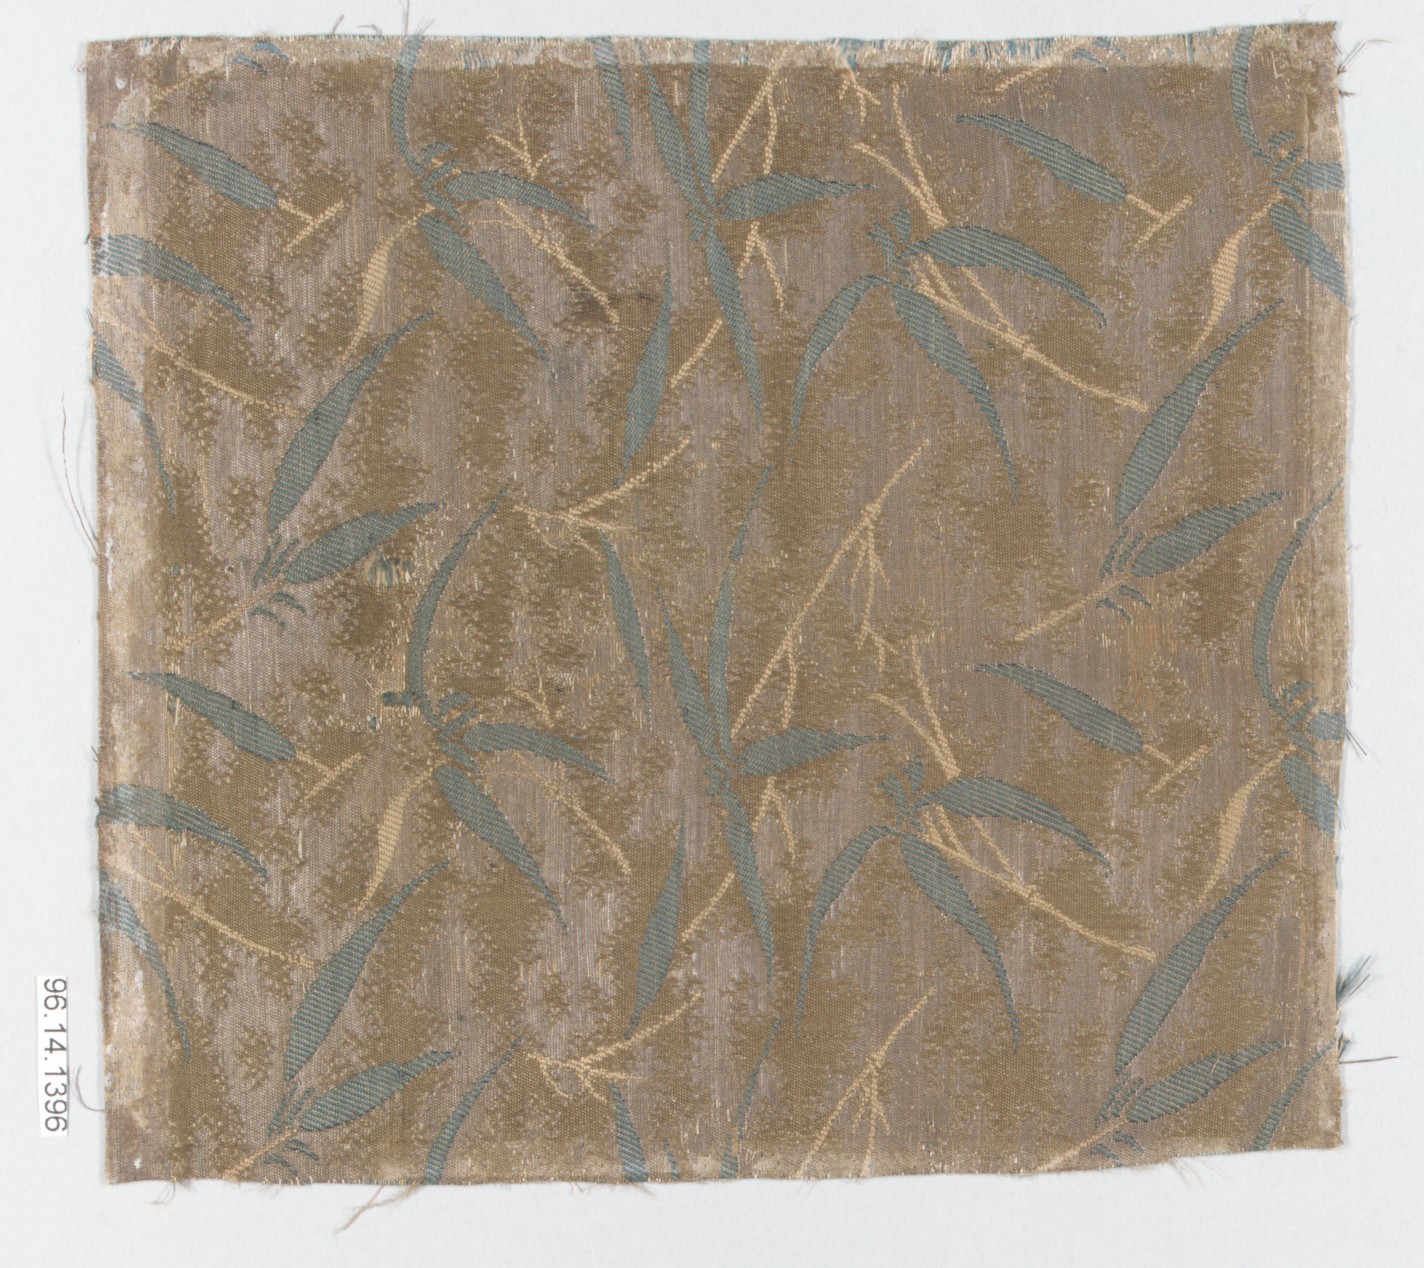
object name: piece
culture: japanese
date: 1801-1900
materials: metal thread, silk